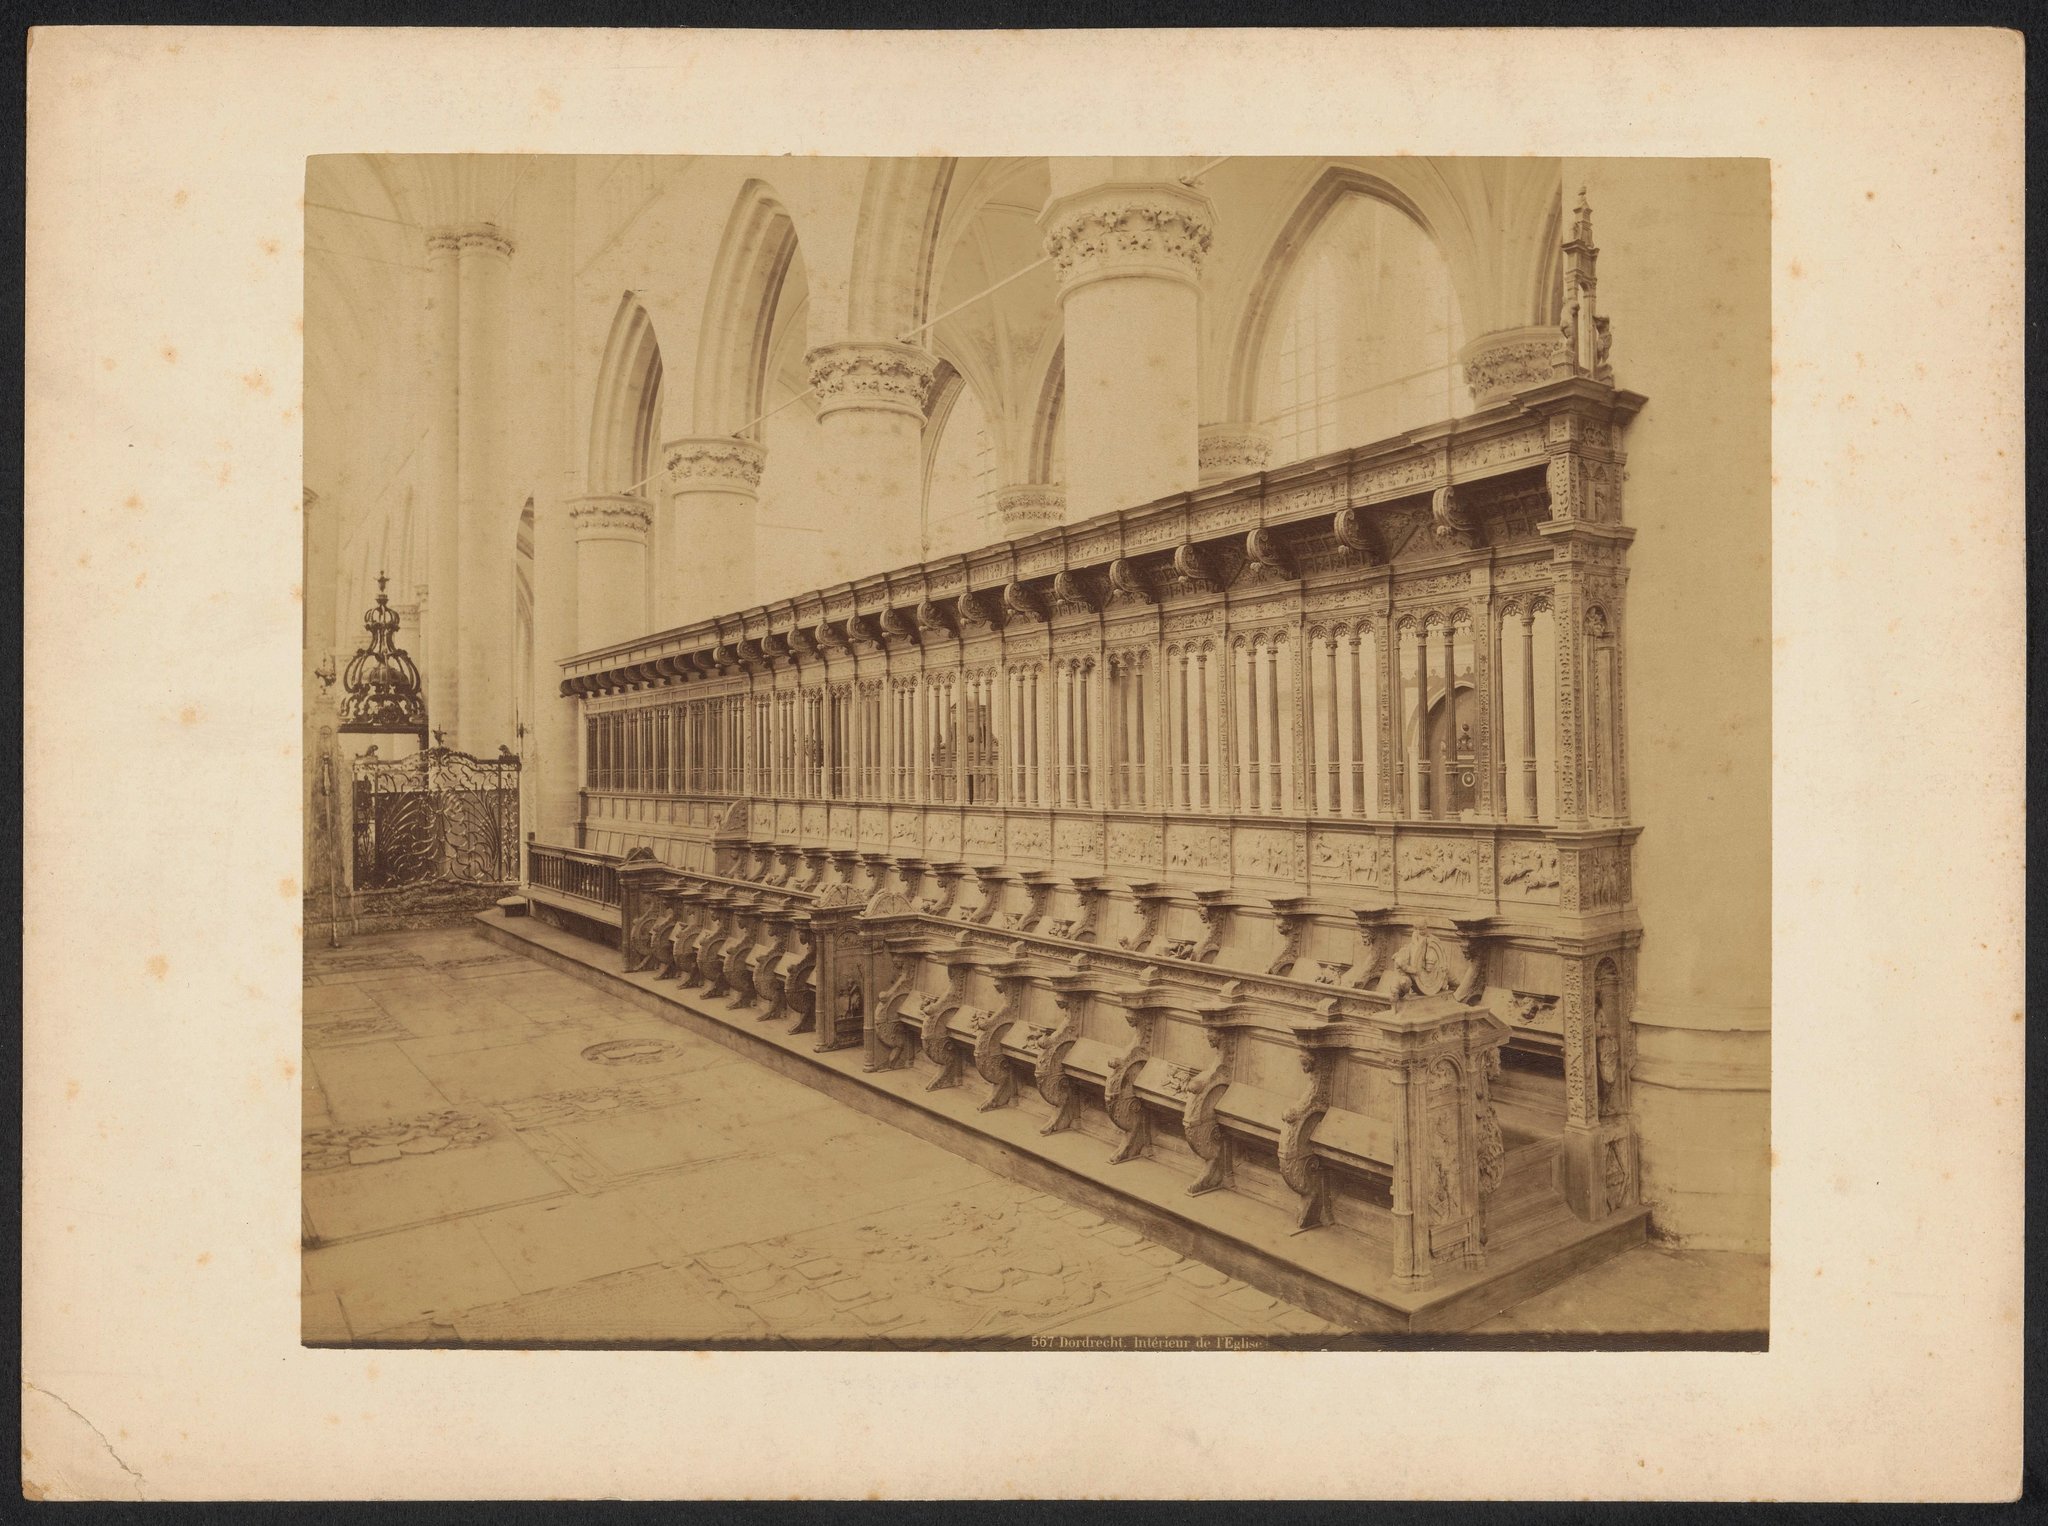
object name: photograph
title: Koorbanken in de Grote Kerk te Dordrecht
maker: Anonymous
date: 1875-1900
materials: cardboard, photographic support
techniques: albumen print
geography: grote of onze-lieve-vrouwekerk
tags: interior of church, seats of the clergy, choir-stalls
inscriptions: number: ‘567’, name: ‘S. FRANCO, b. i. den Haag.’